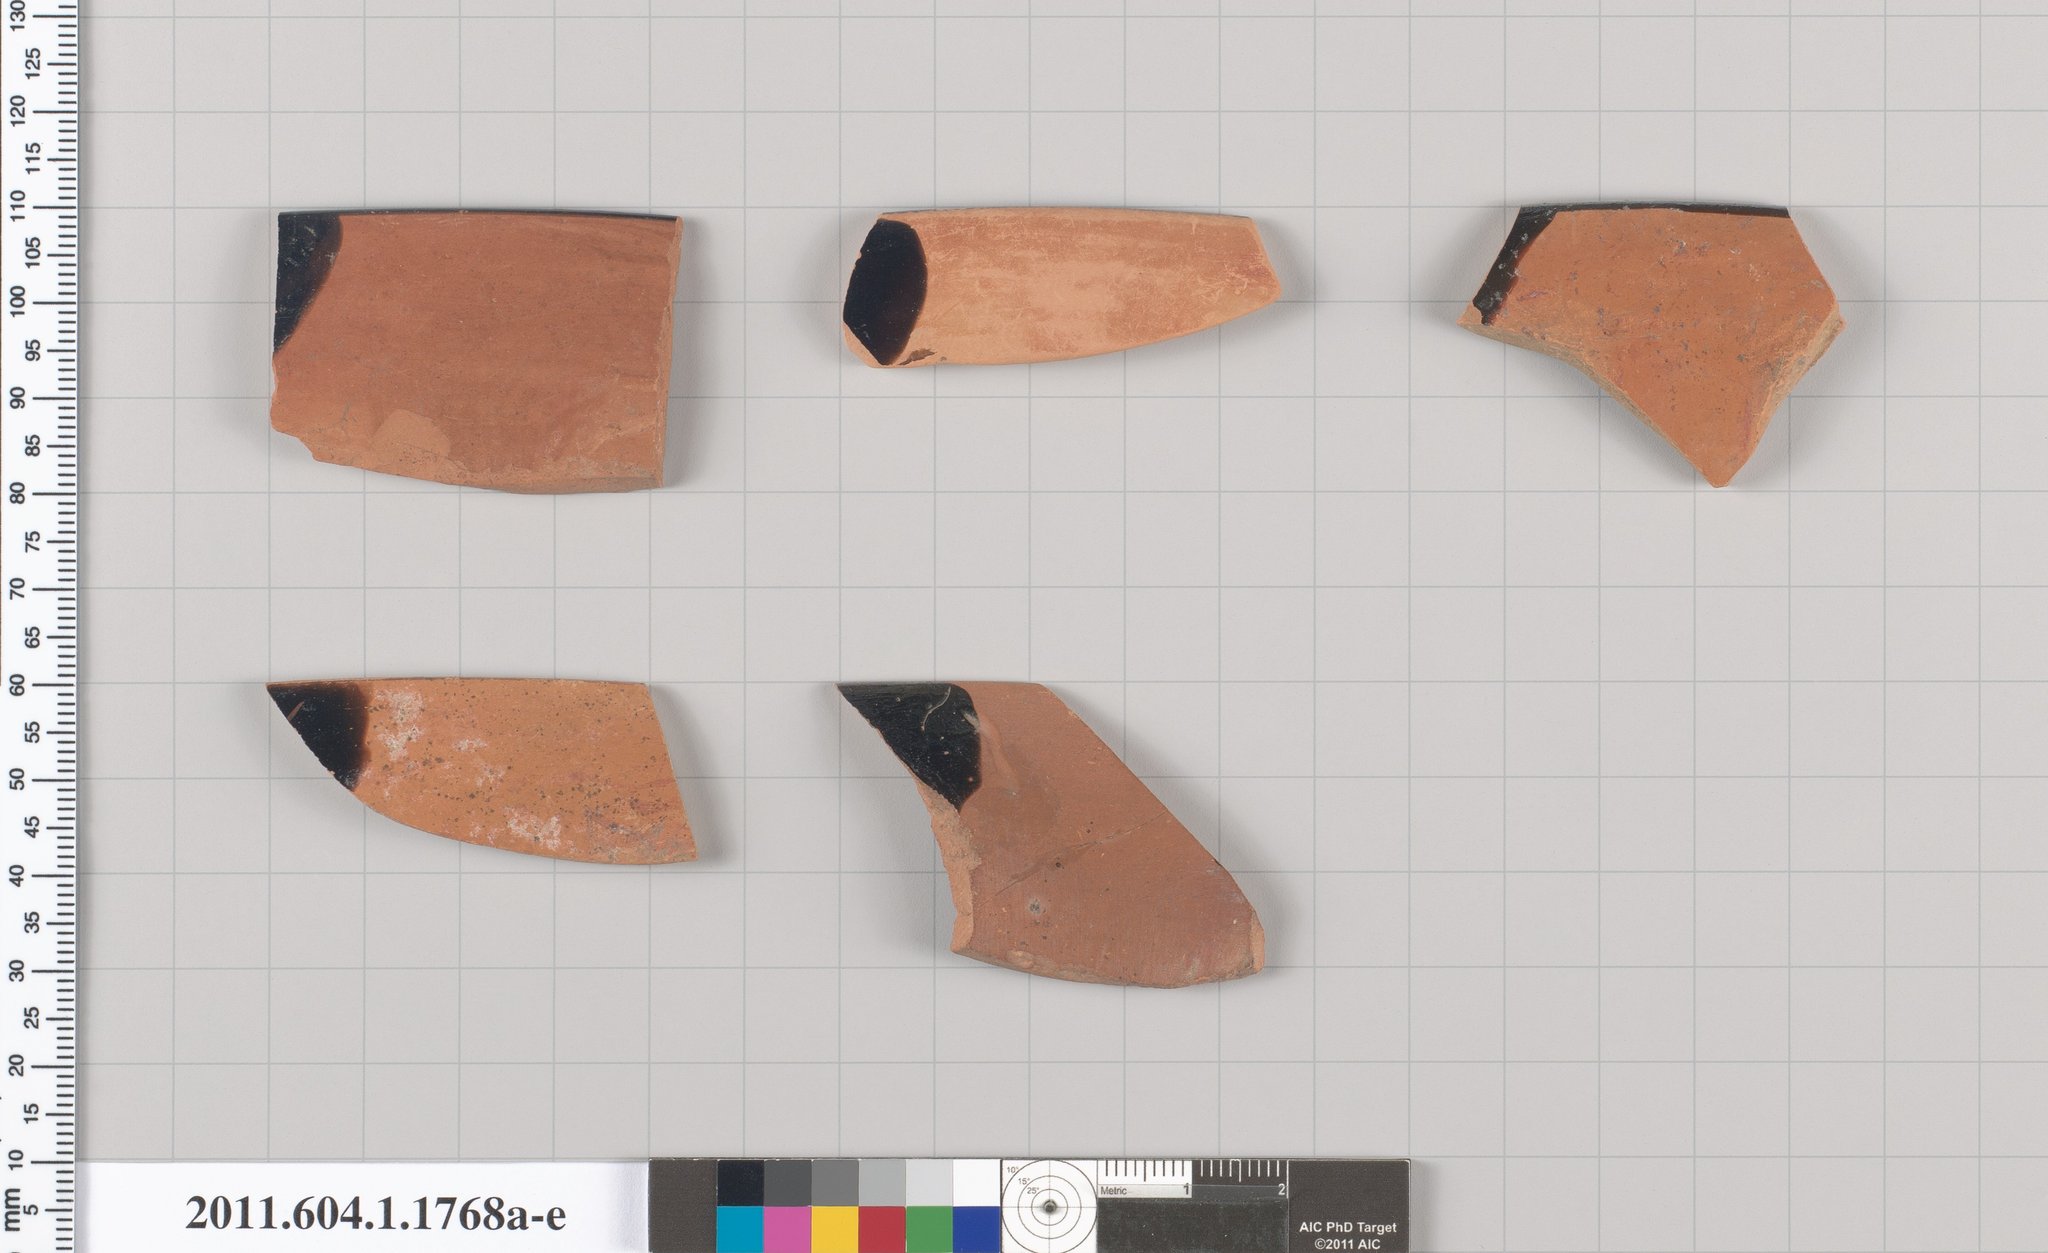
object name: kylix fragment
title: Terracotta rim fragments of kylikes(drinking cups)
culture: greek, attic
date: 500-401 BCE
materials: terracotta